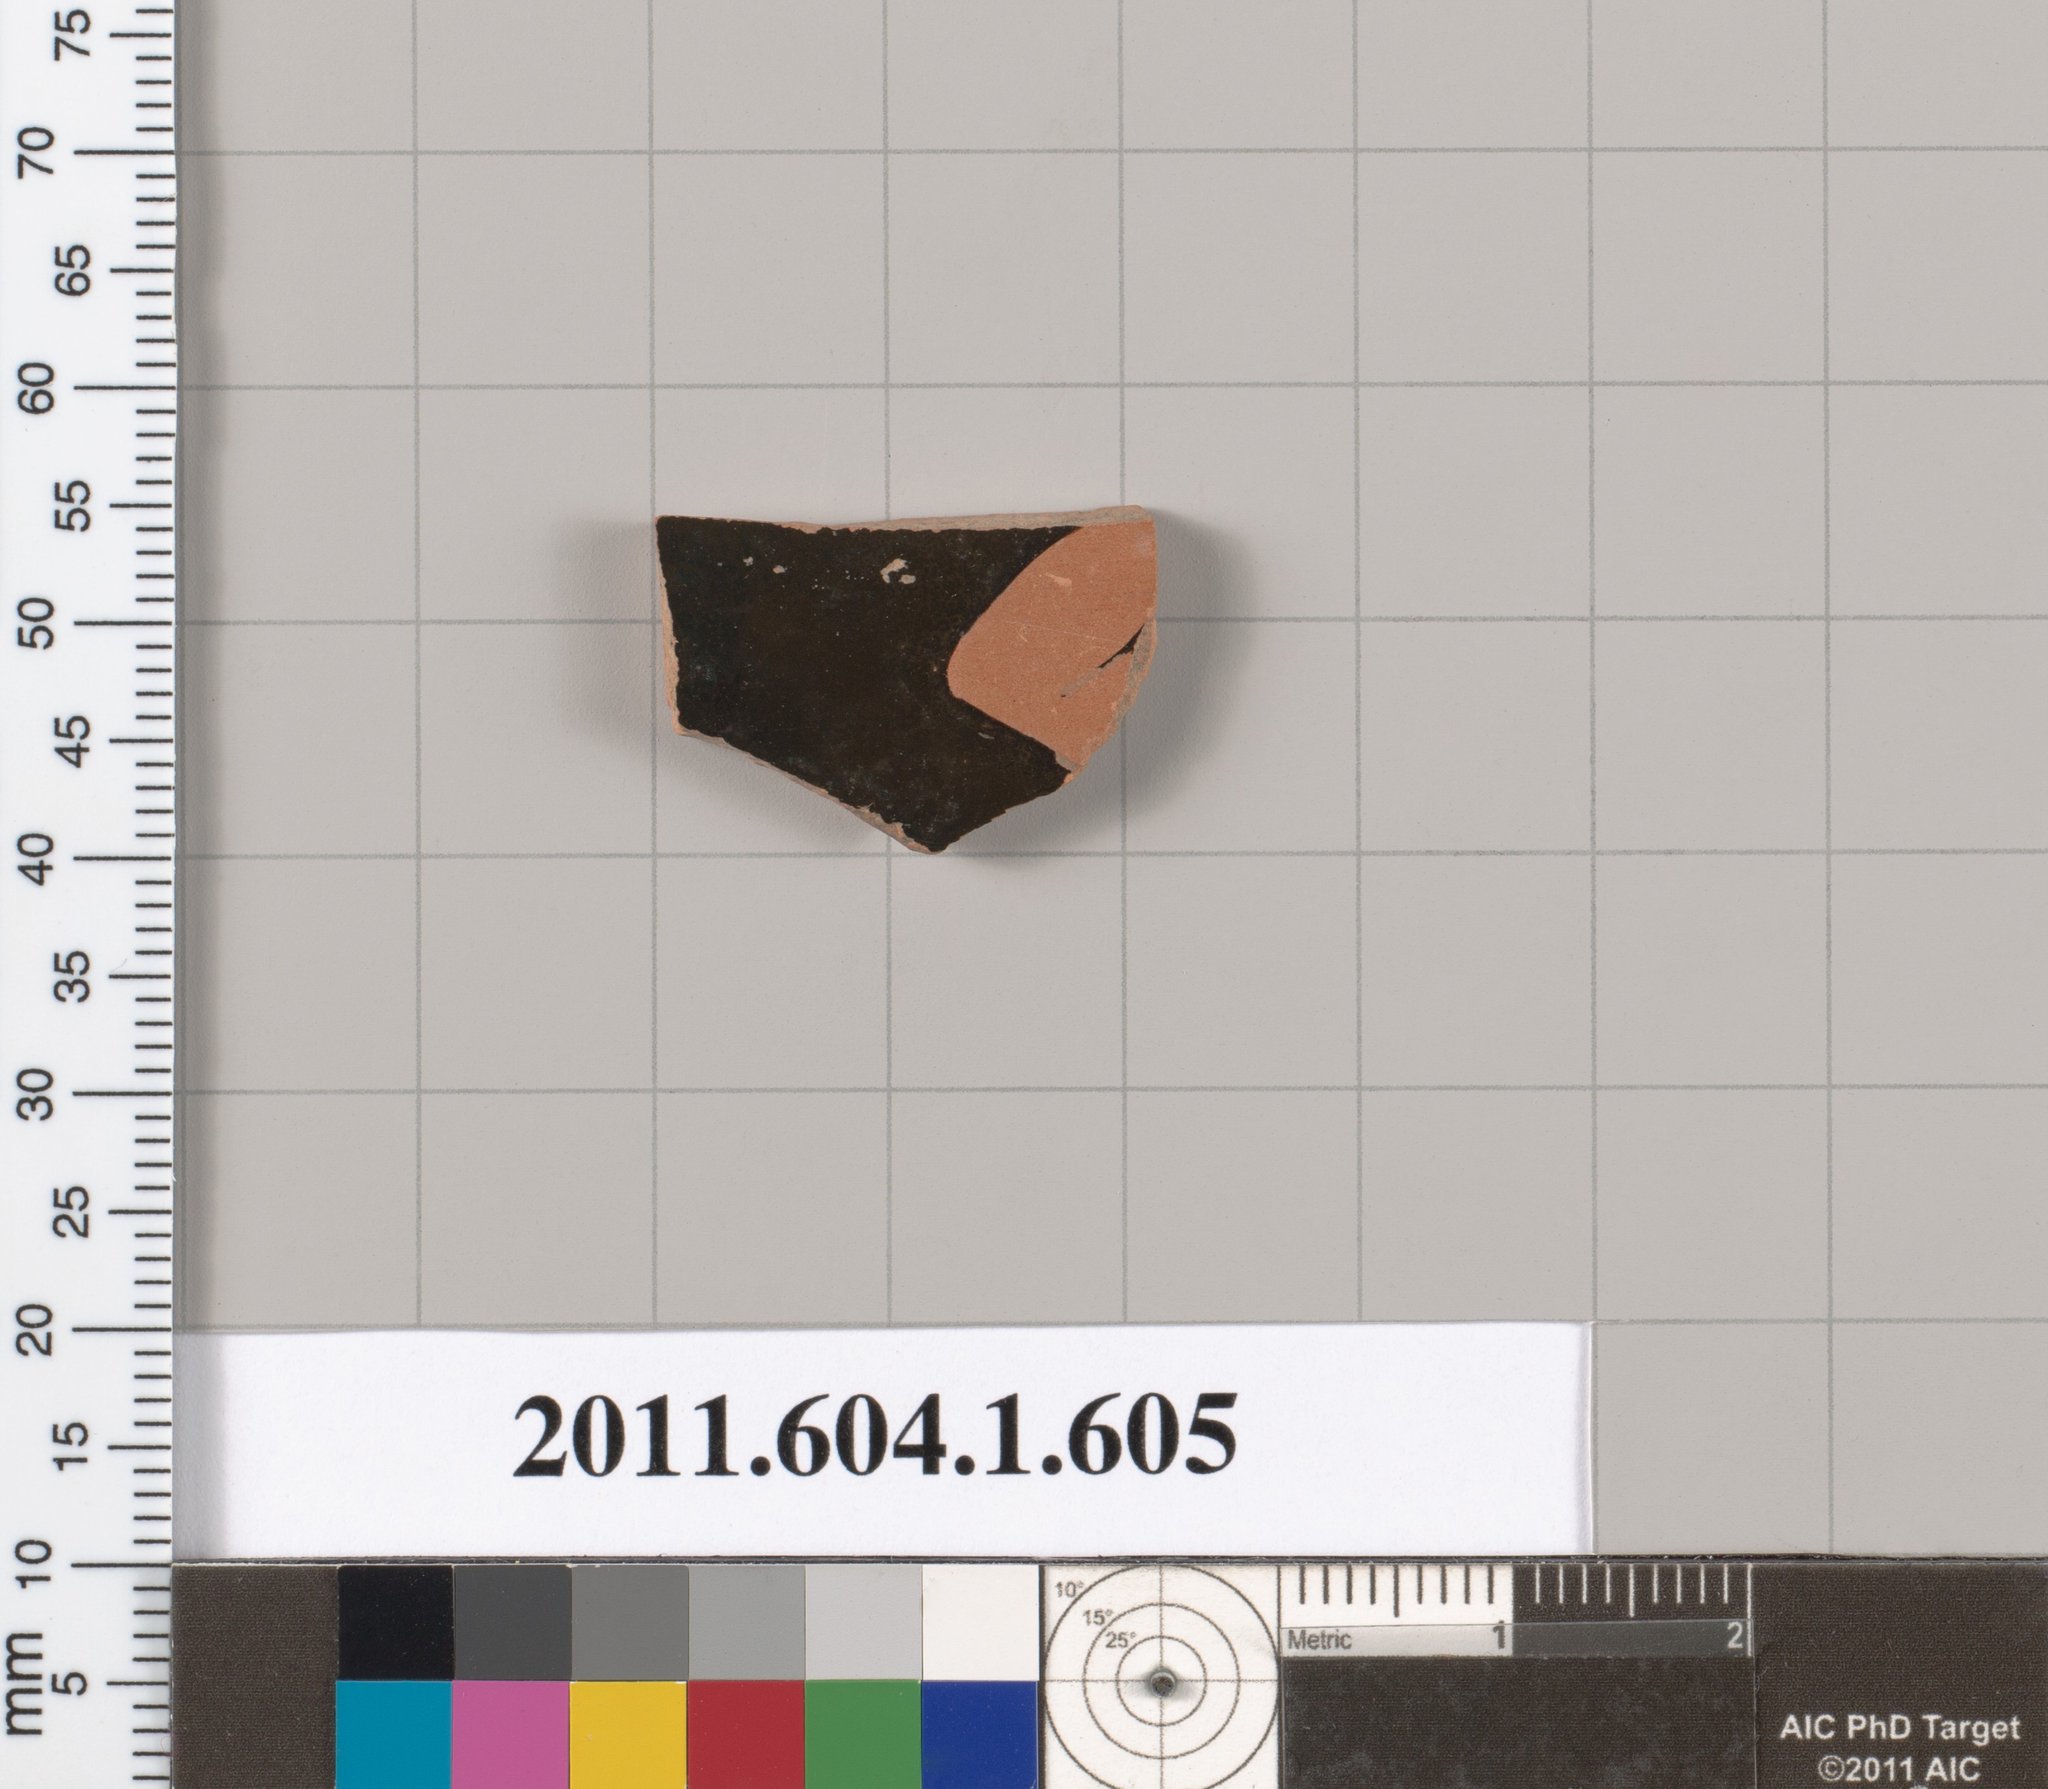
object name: kylix fragment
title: Terracotta fragment of a kylix (drinking cup)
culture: greek, attic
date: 475-451 BCE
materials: terracotta